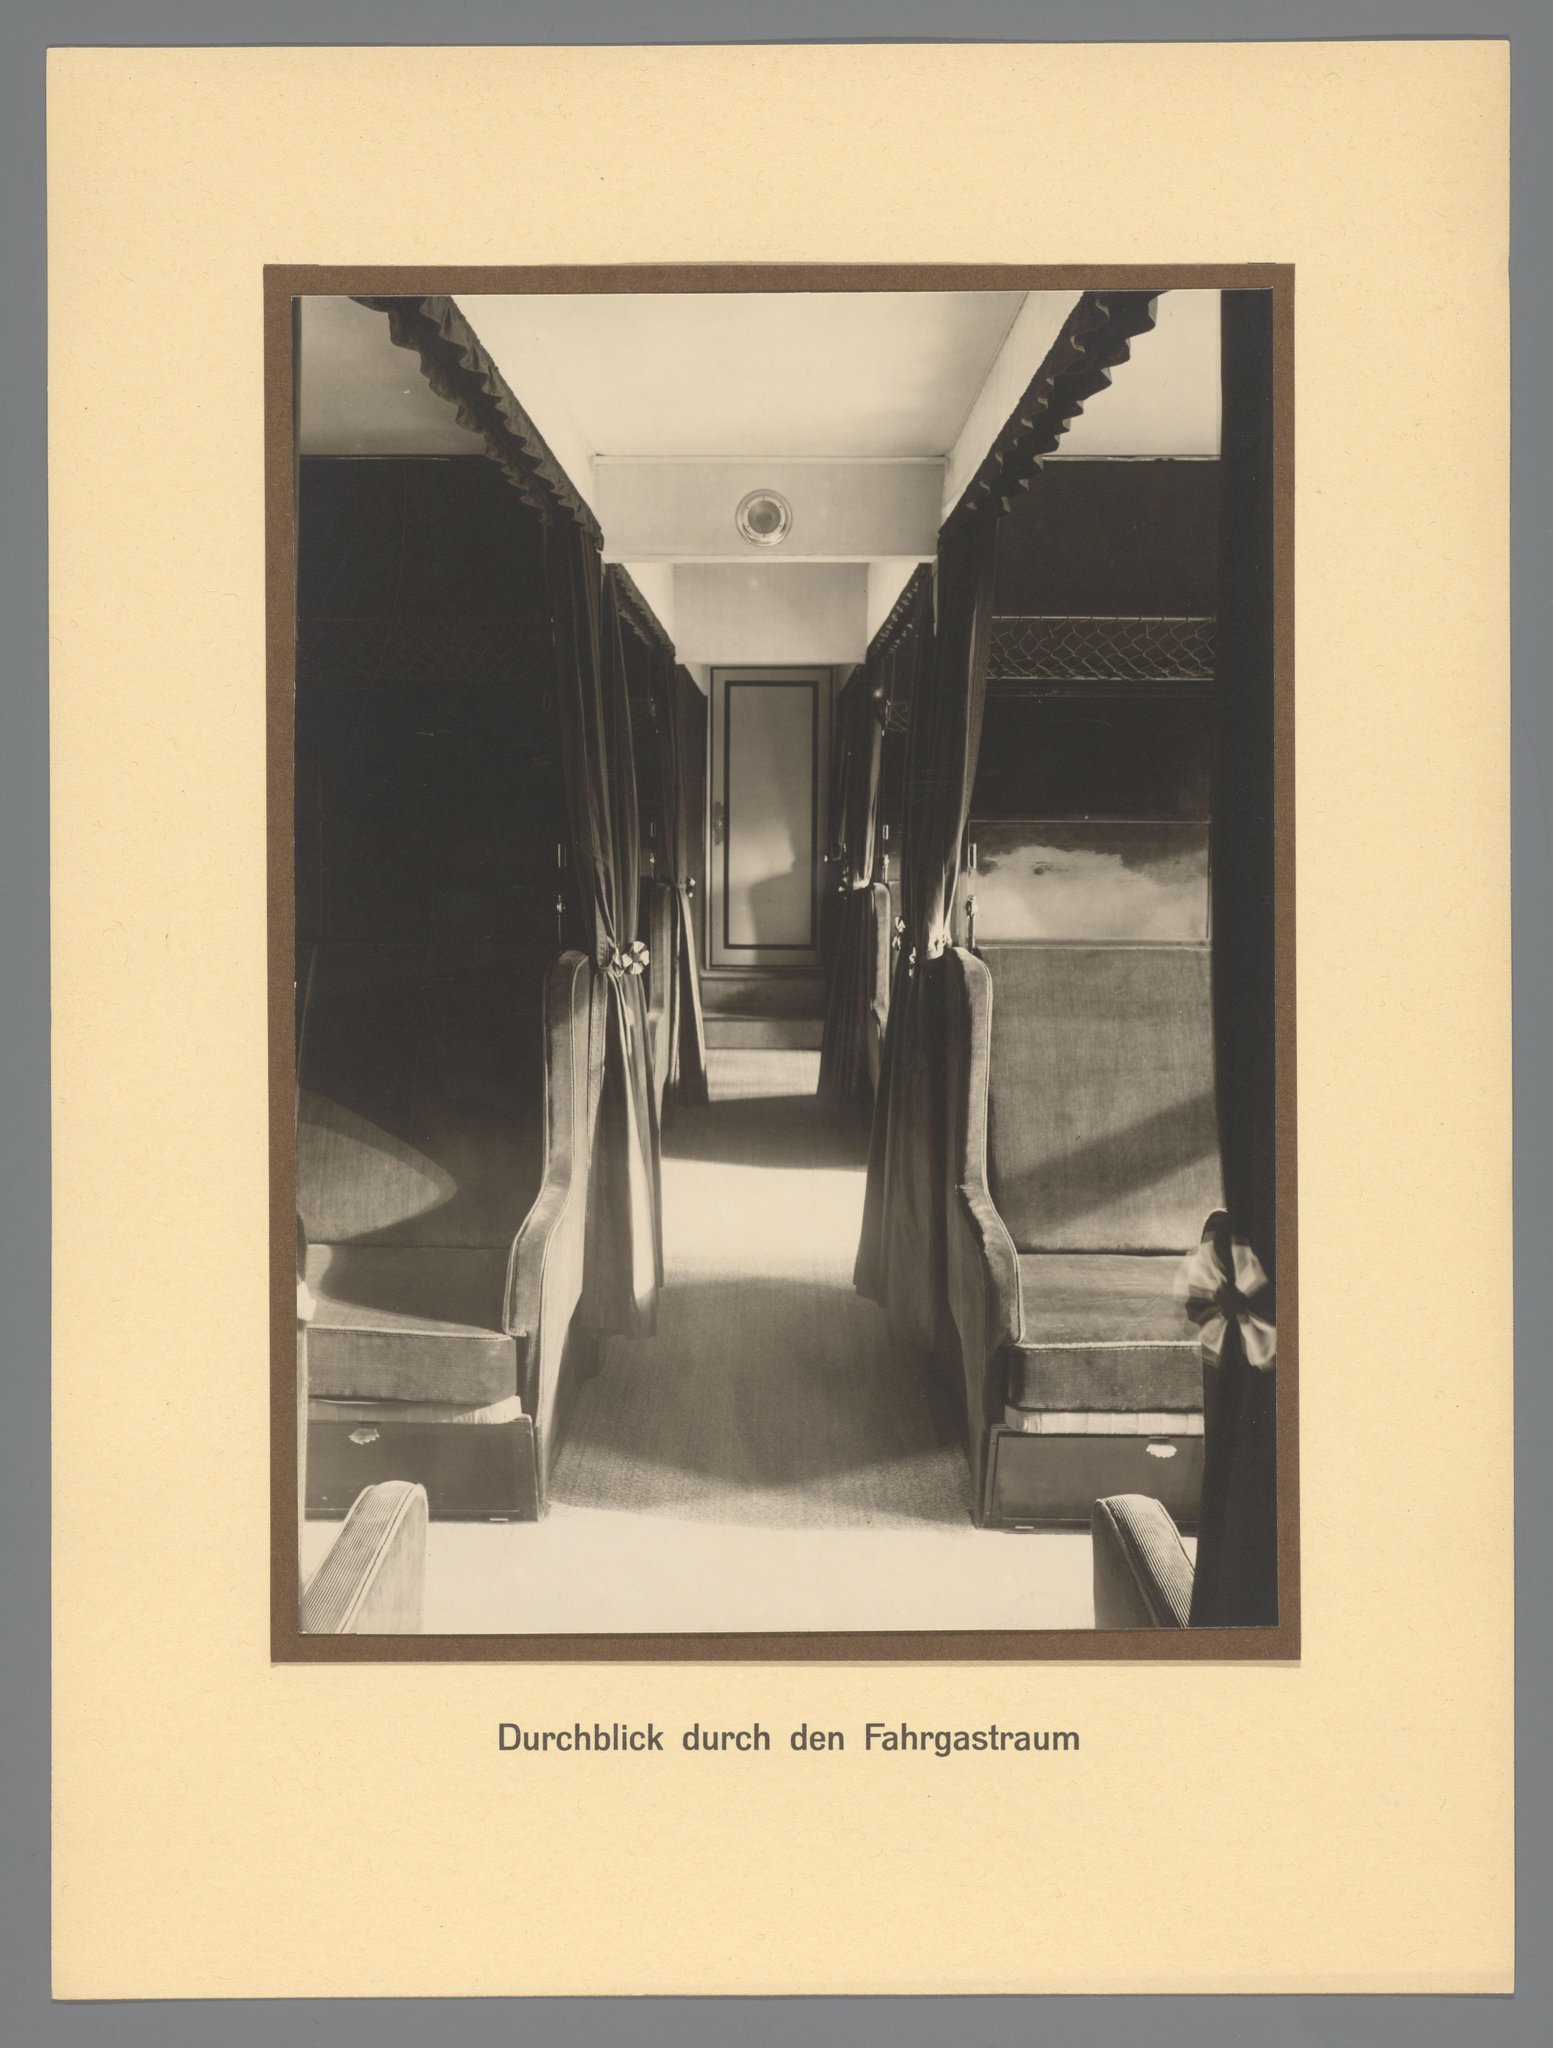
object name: photograph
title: Gezicht in het passgierscompartiment van de zeppelin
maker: Anonymous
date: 1924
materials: cardboard, photographic support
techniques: gelatin silver print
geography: germany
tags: airship, zeppelin (+ view ~ vehicle, ship, etc.)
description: Gezicht in het passgierscompartiment van de zeppelin. Onderdeel van een map twintig productfoto's van het Zeppelinluchtschip LZ 126.